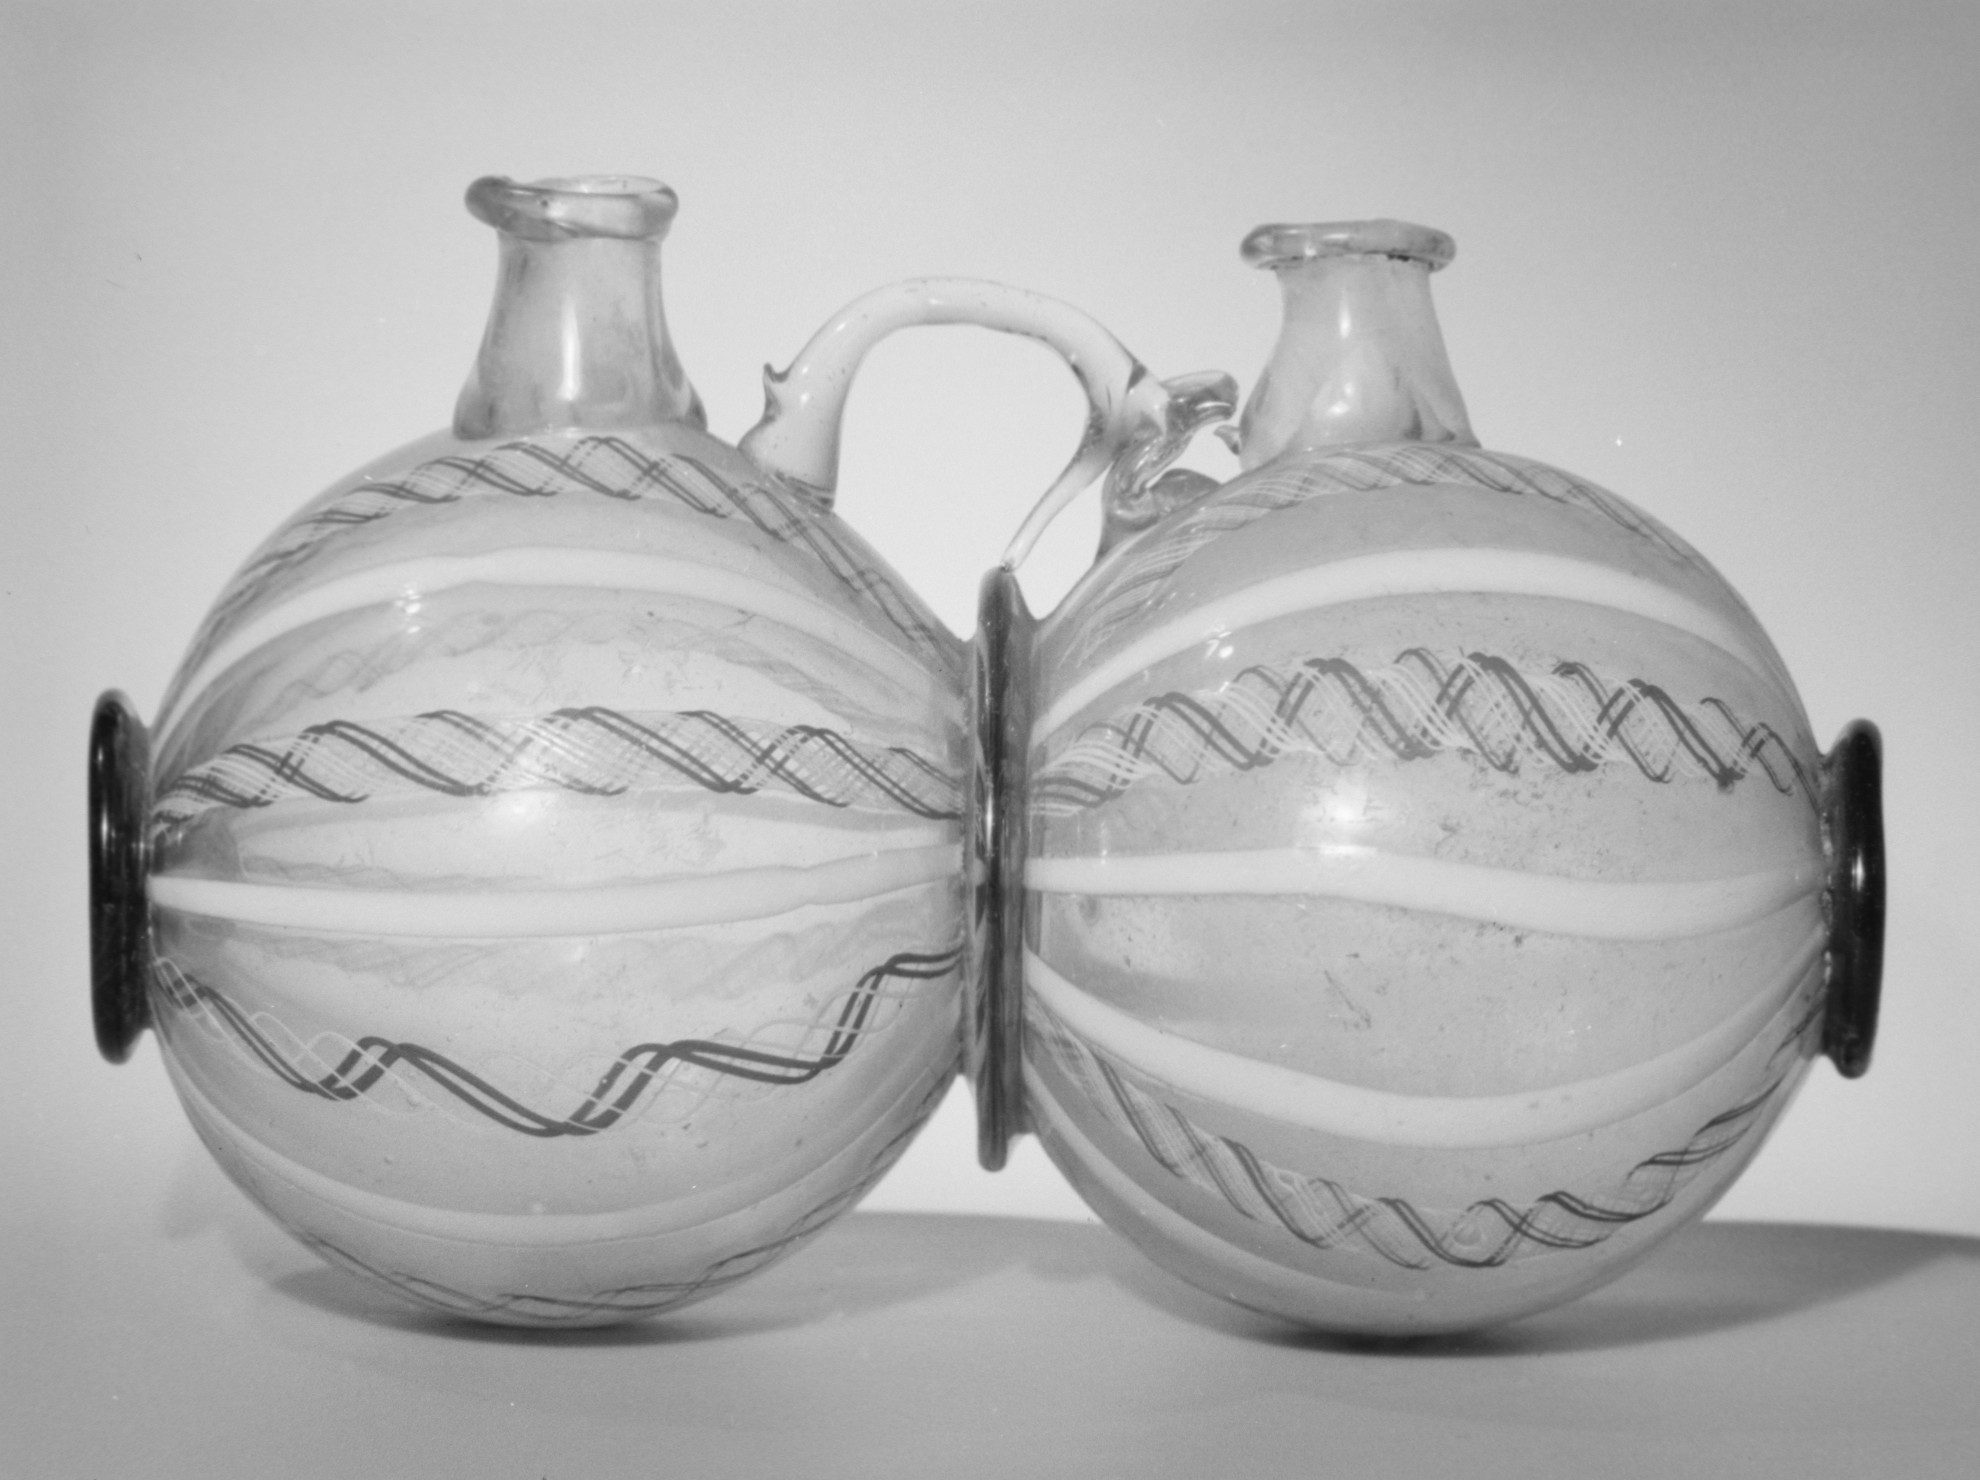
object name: double bottle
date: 1601-1800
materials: glass